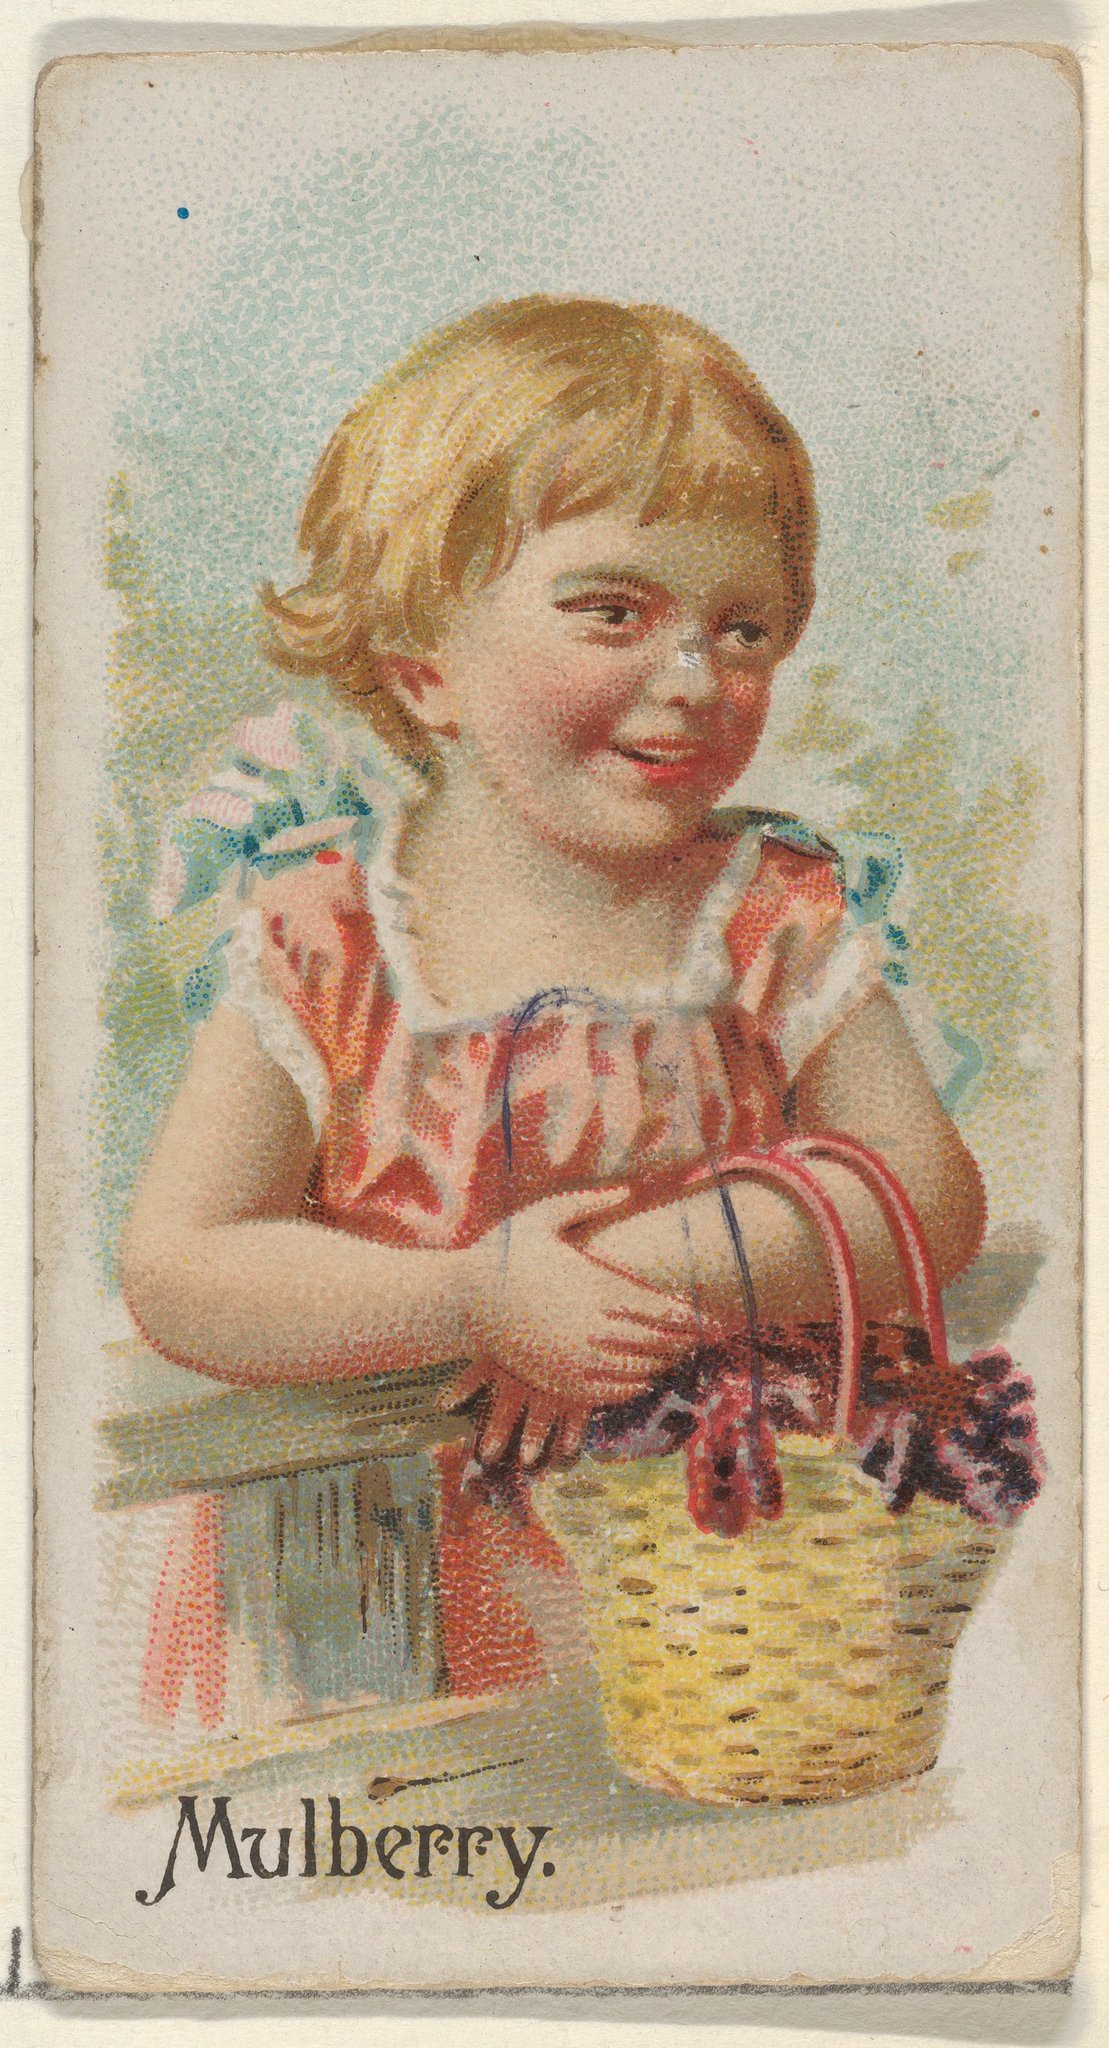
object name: print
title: Mulberry, from the Fruits series (N12) for Allen & Ginter Cigarettes Brands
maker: allen & ginter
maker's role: publisher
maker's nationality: american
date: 1891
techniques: color lithograph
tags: fruit,girls